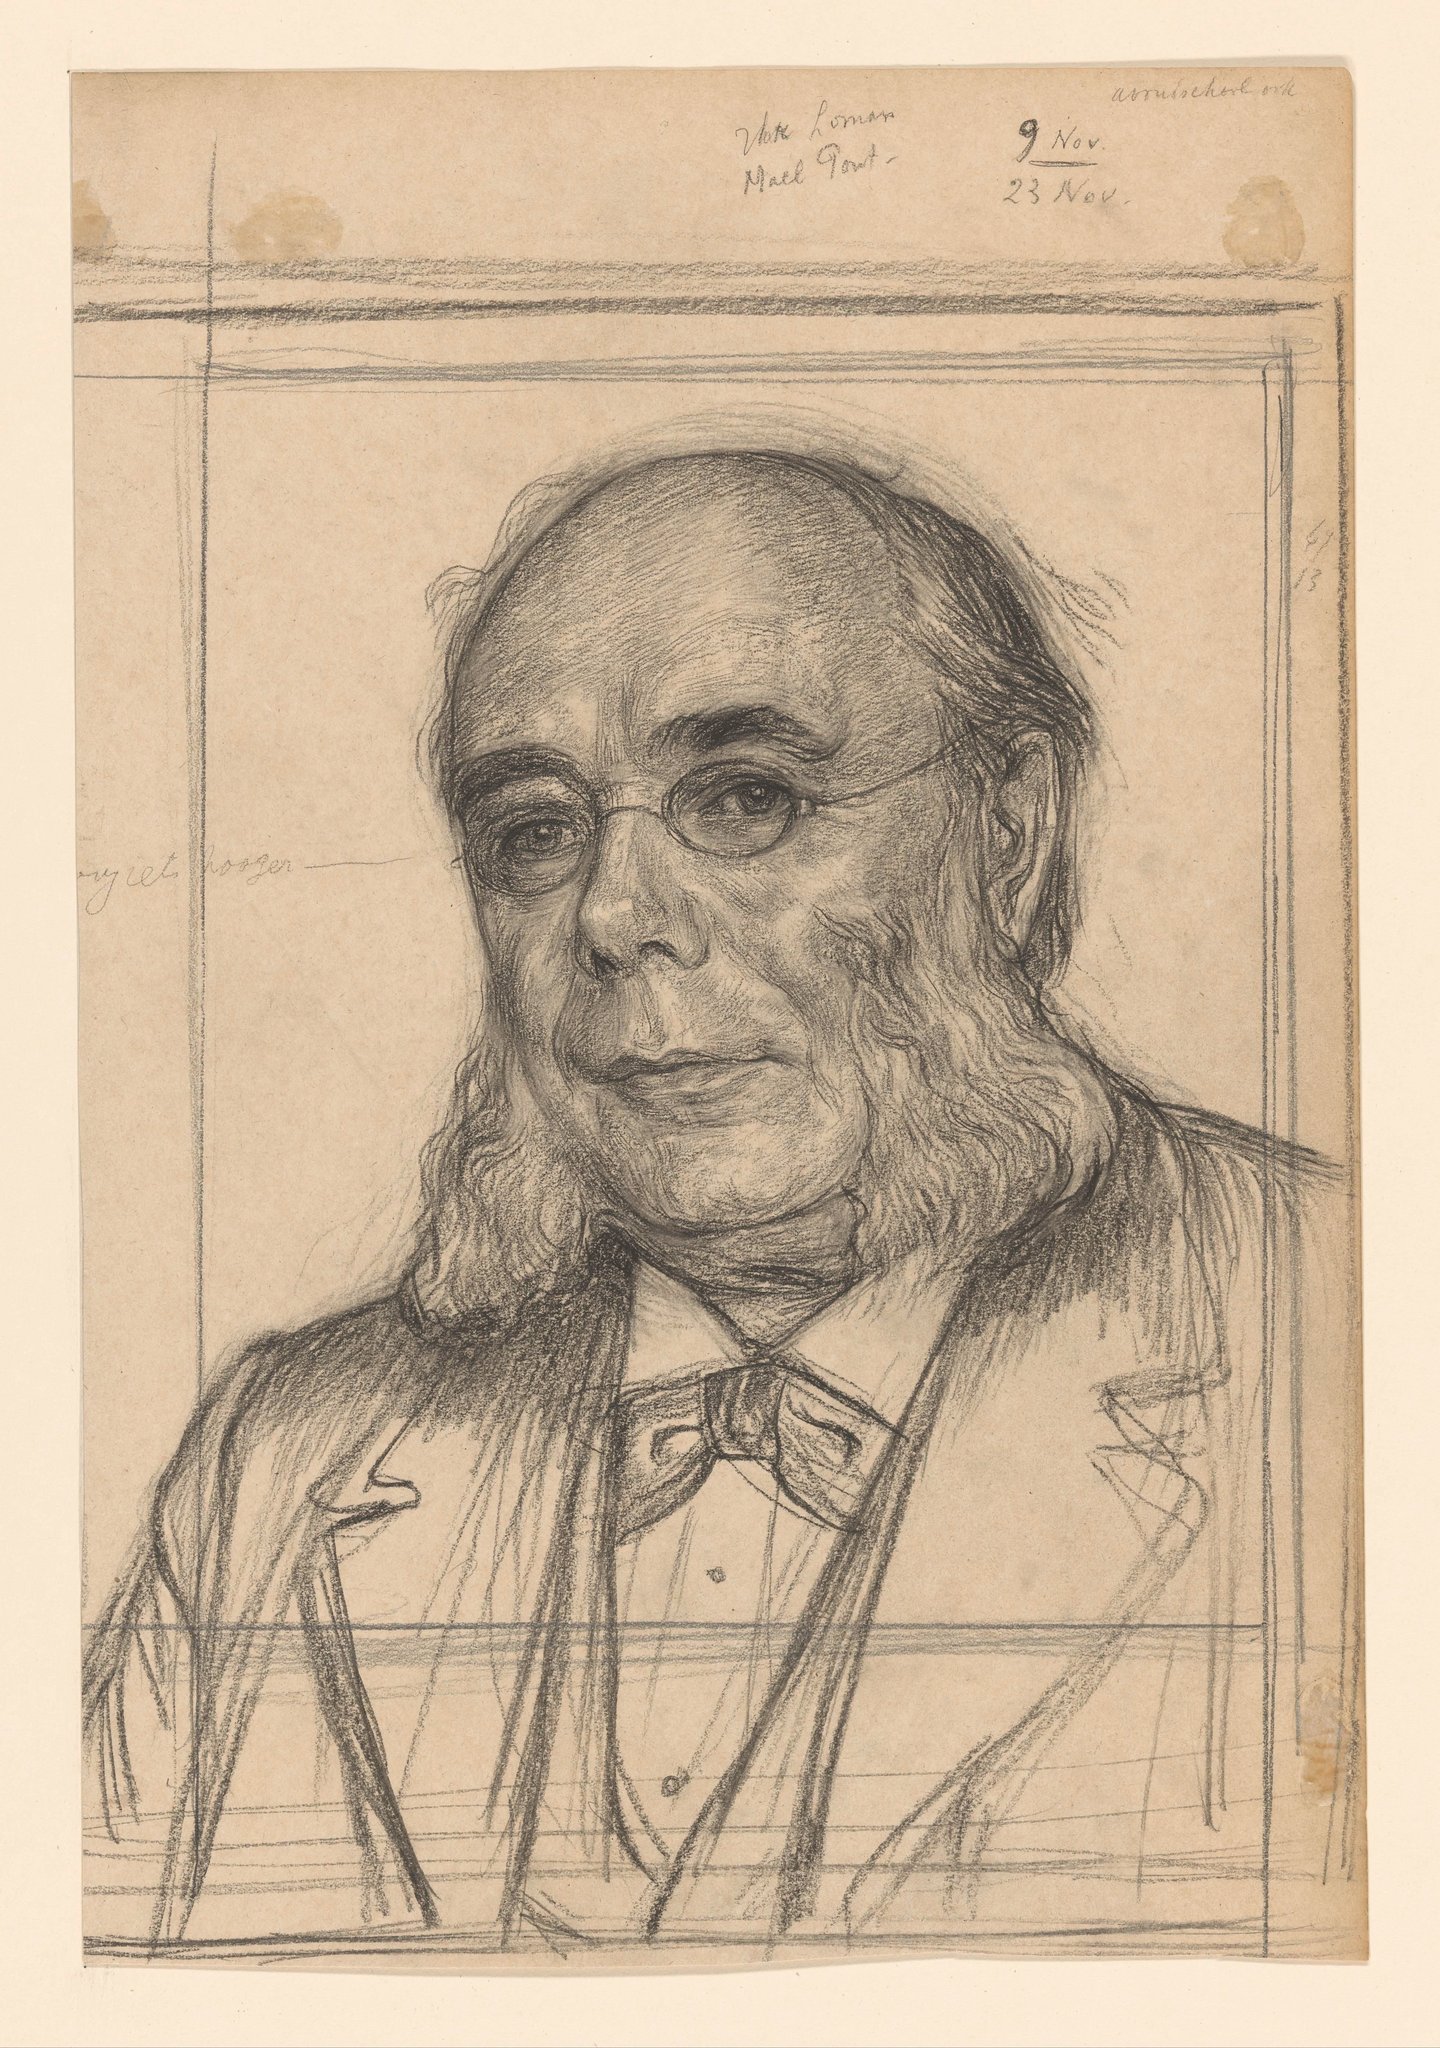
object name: drawing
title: Portret van dr. H. Pierson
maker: jan veth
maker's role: designer, draughtsman, painter, print maker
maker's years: 1864-1925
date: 1874-1925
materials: chalk, paper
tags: historical persons